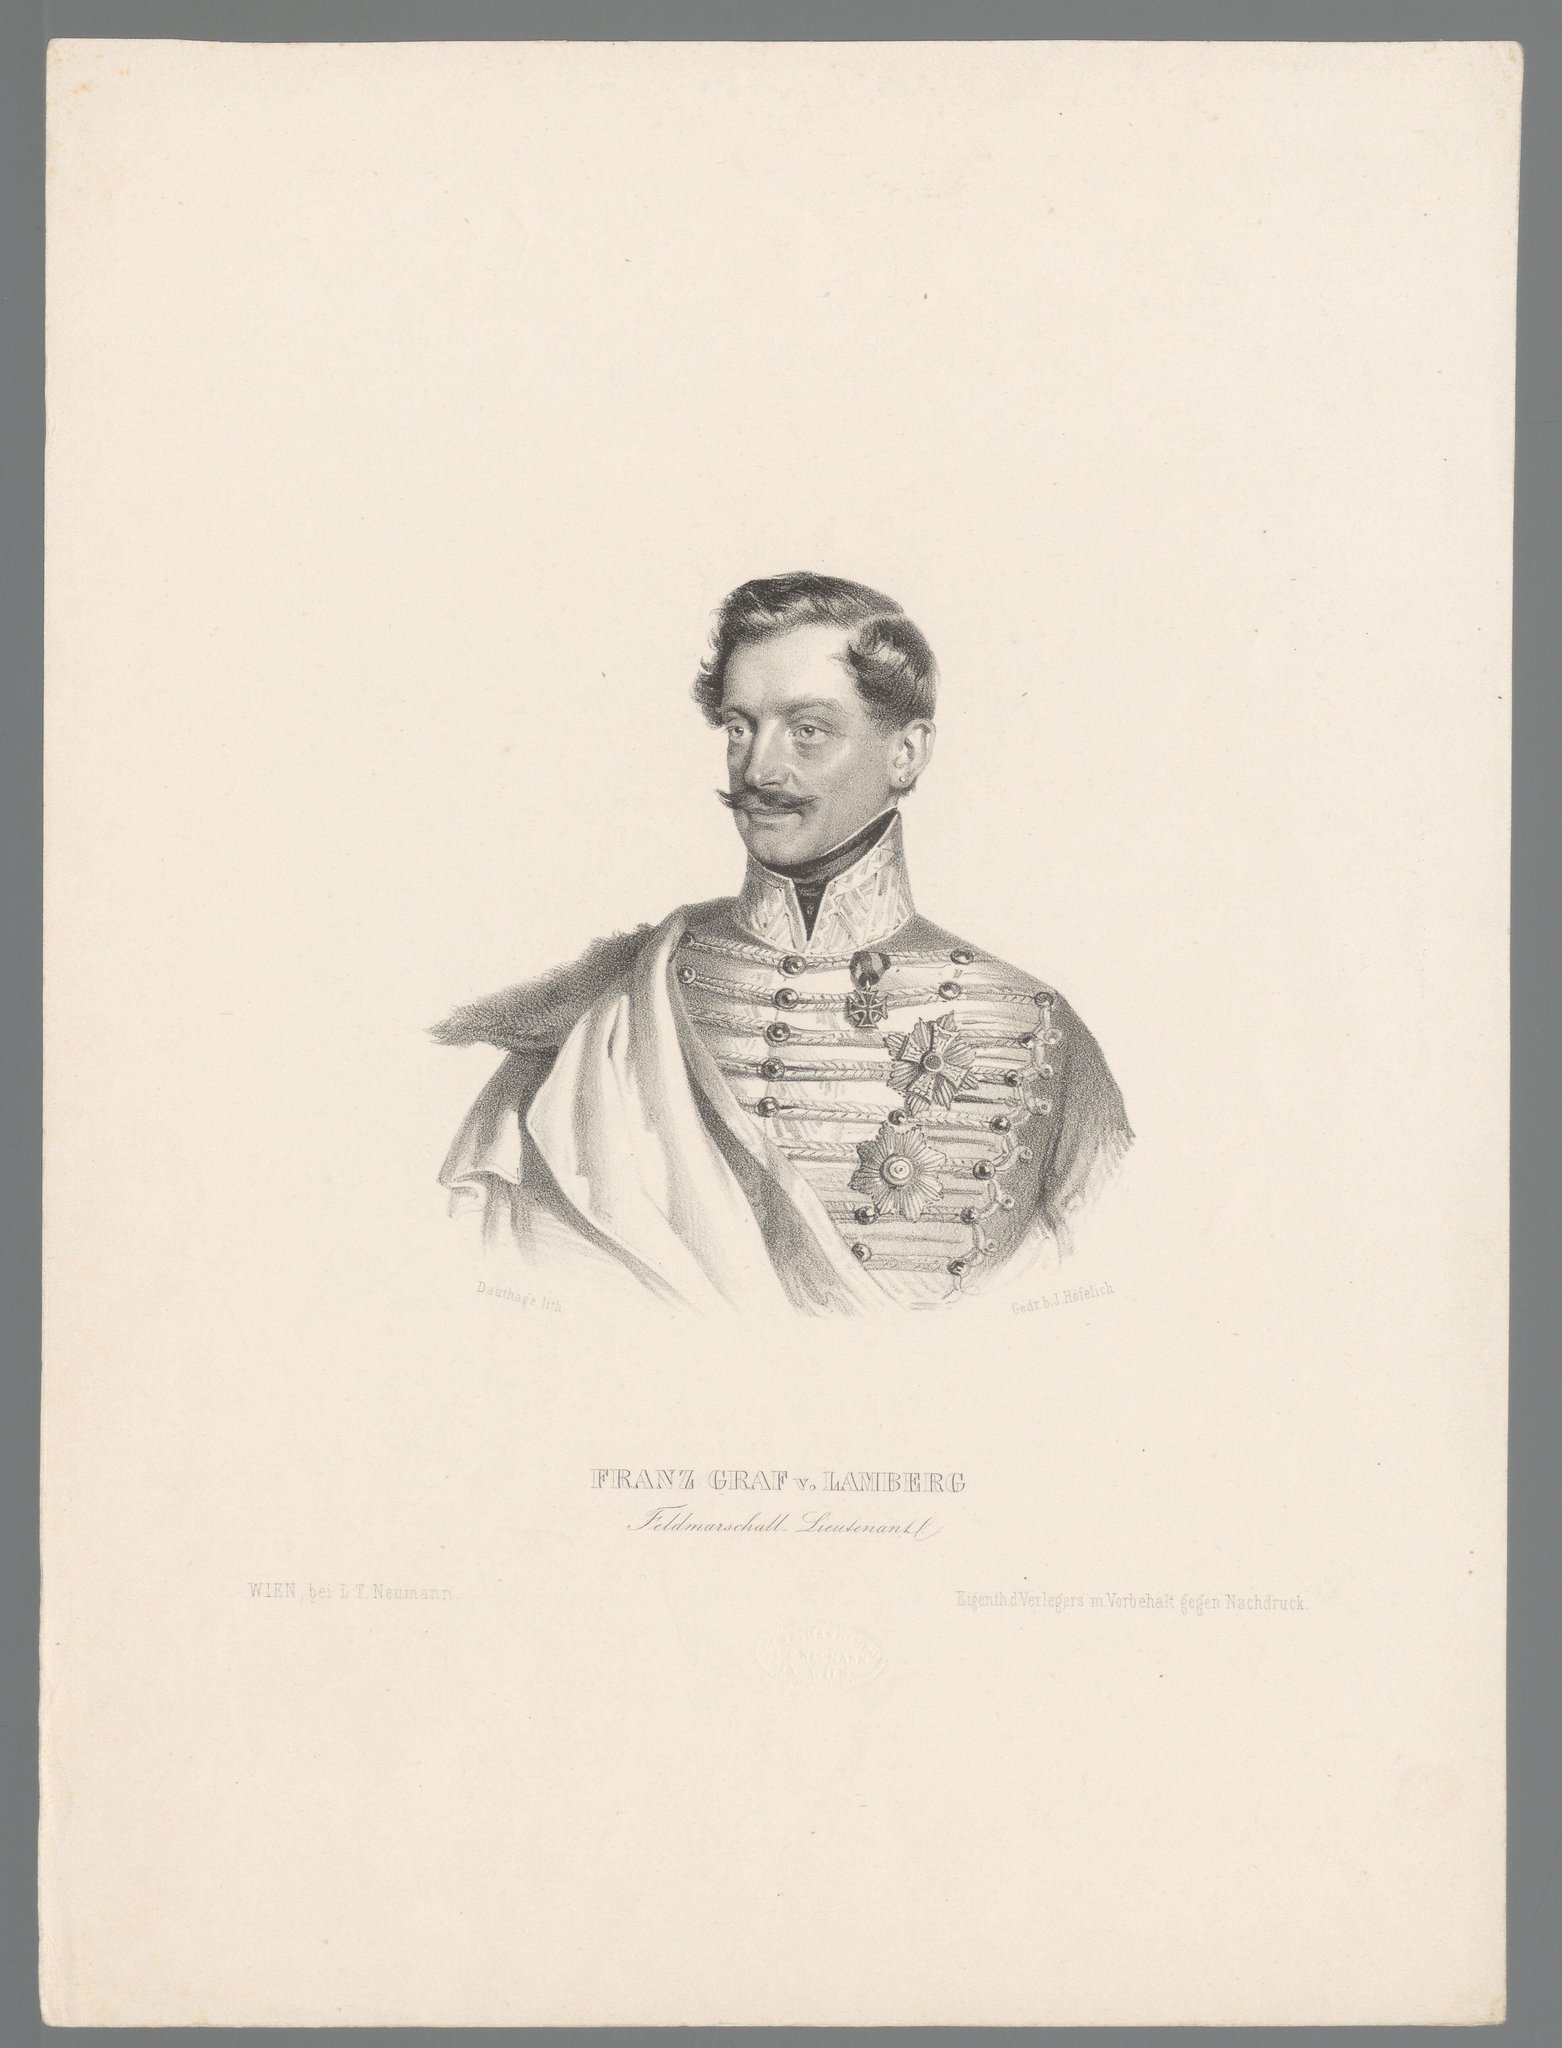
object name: print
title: Portret van Franz Philipp von Lamberg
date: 1835-1849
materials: paper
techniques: lithograph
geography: vienna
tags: commander-in-chief, general, marshal, historical persons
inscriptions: collector's mark: Lugt 2228, check stamp: ‘Kunsthandlung L.T. Neumann im Wien’